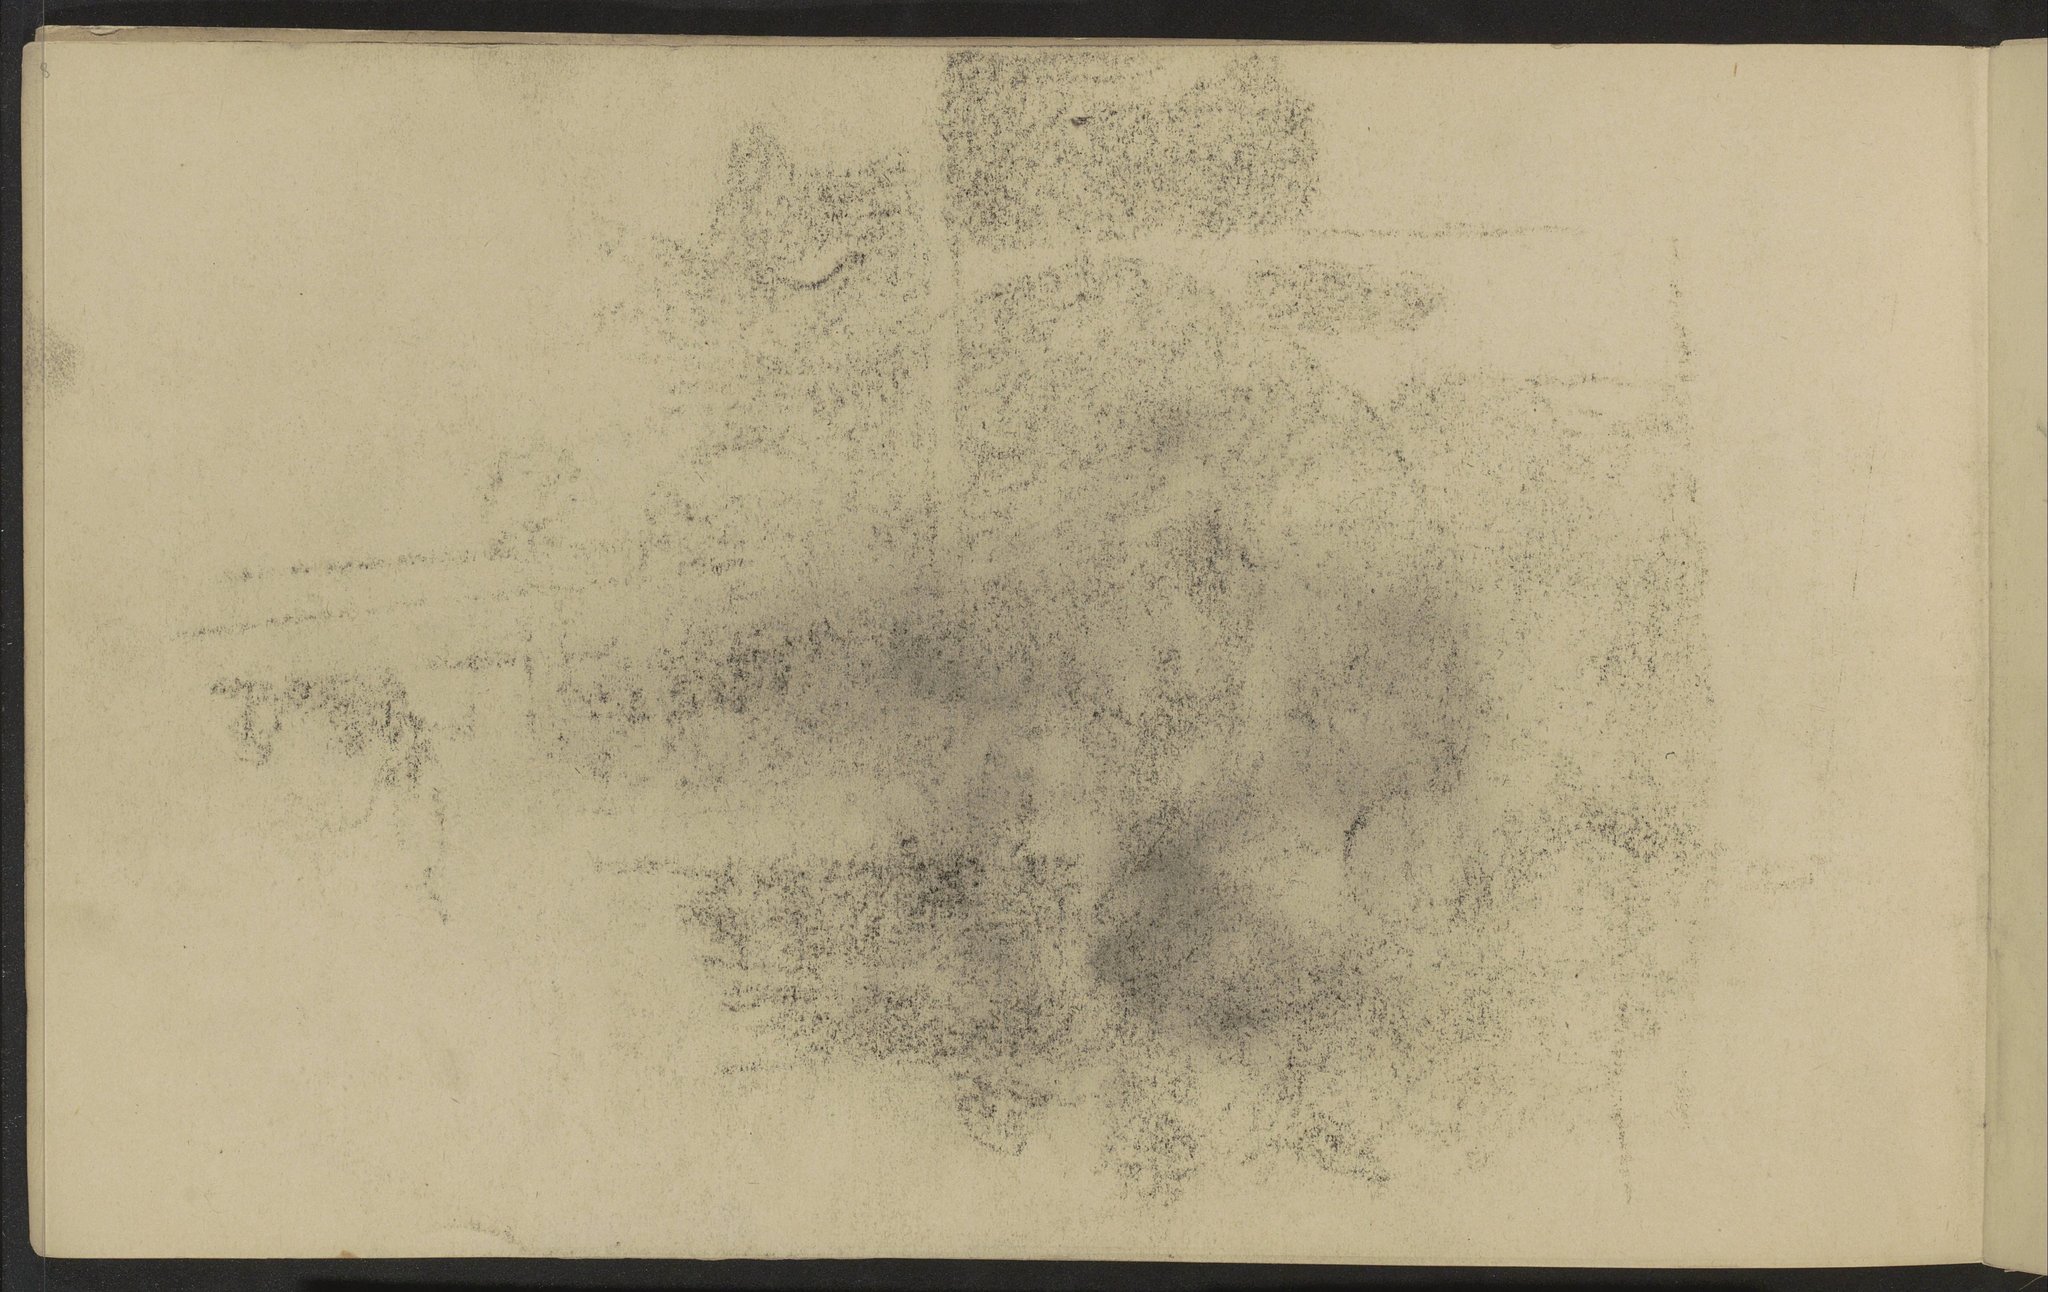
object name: sketchbook leaf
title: Abklatsch van de krijttekening op pagina 9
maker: willem witsen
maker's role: draughtsman, painter, print maker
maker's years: 1860-1923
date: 1897-1910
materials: paper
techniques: printmaking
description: Pagina 8 uit een schetsboek met 19 bladen.